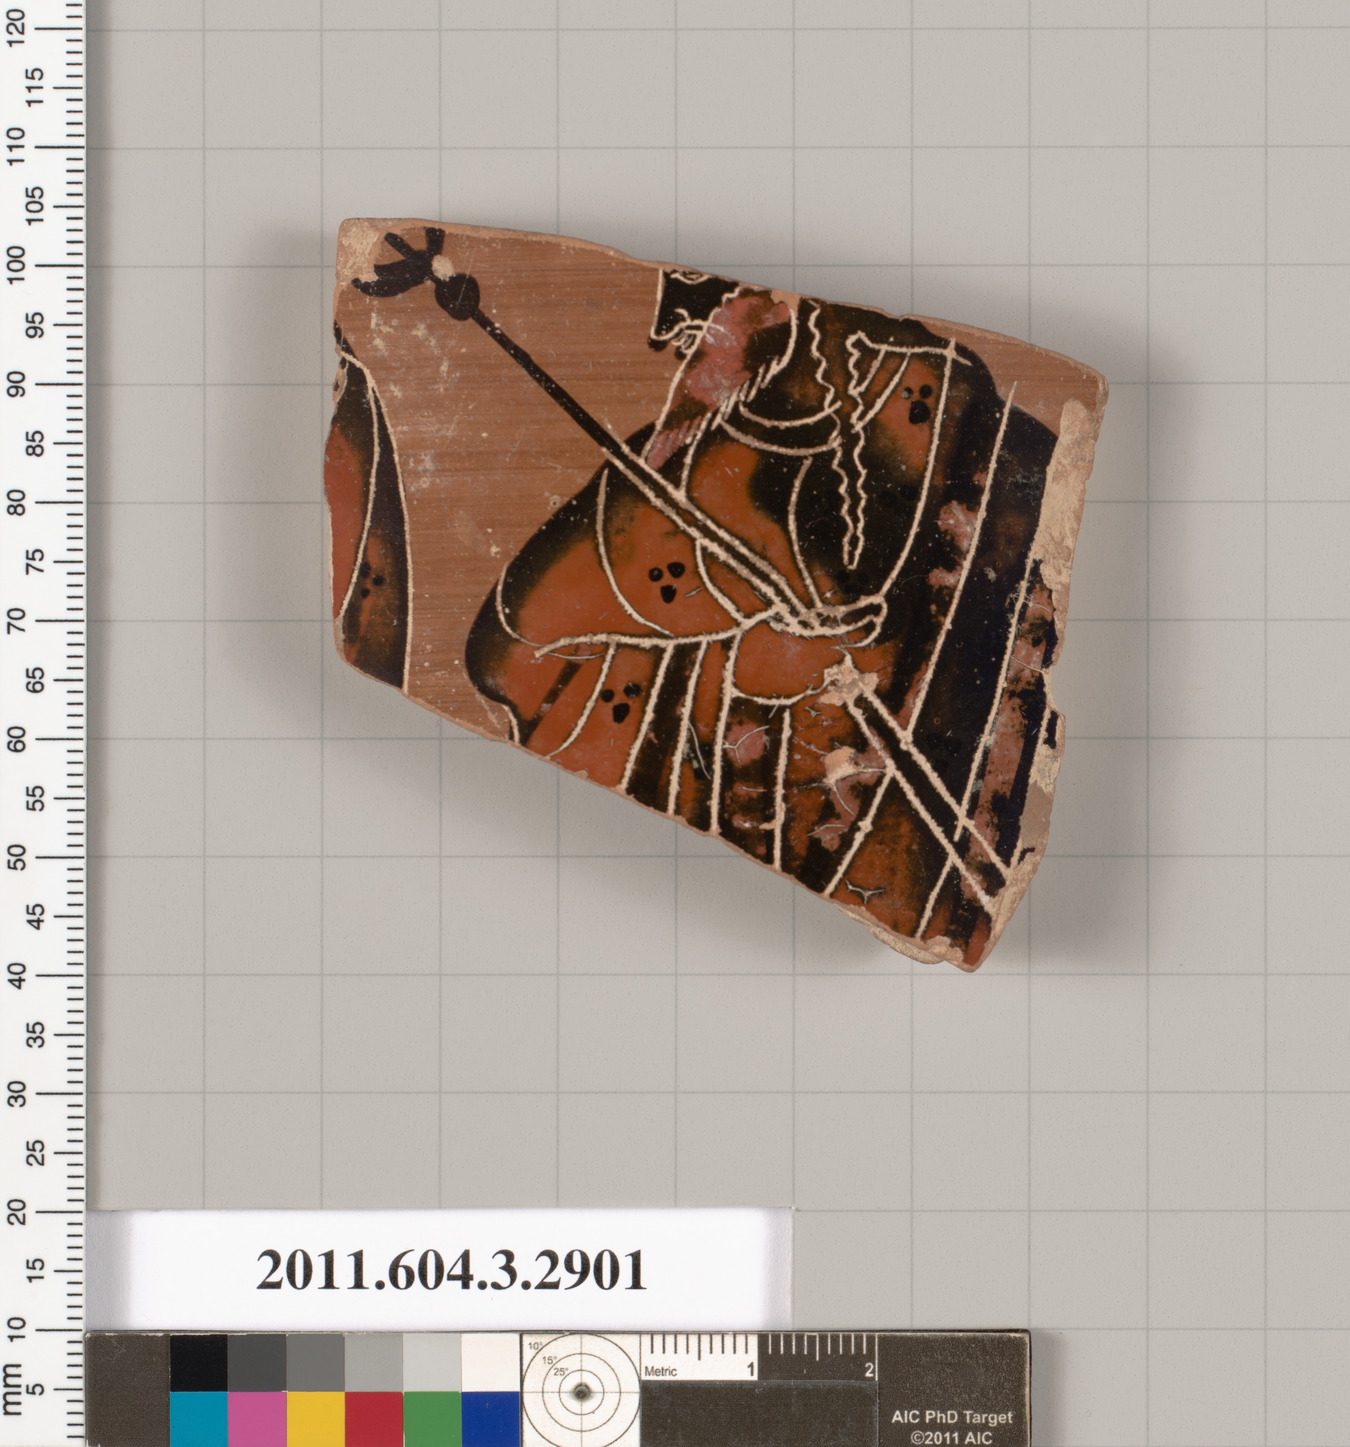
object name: amphora fragment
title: Terracotta fragment of an amphora (jar)?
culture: greek, attic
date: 550-526 BCE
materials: terracotta